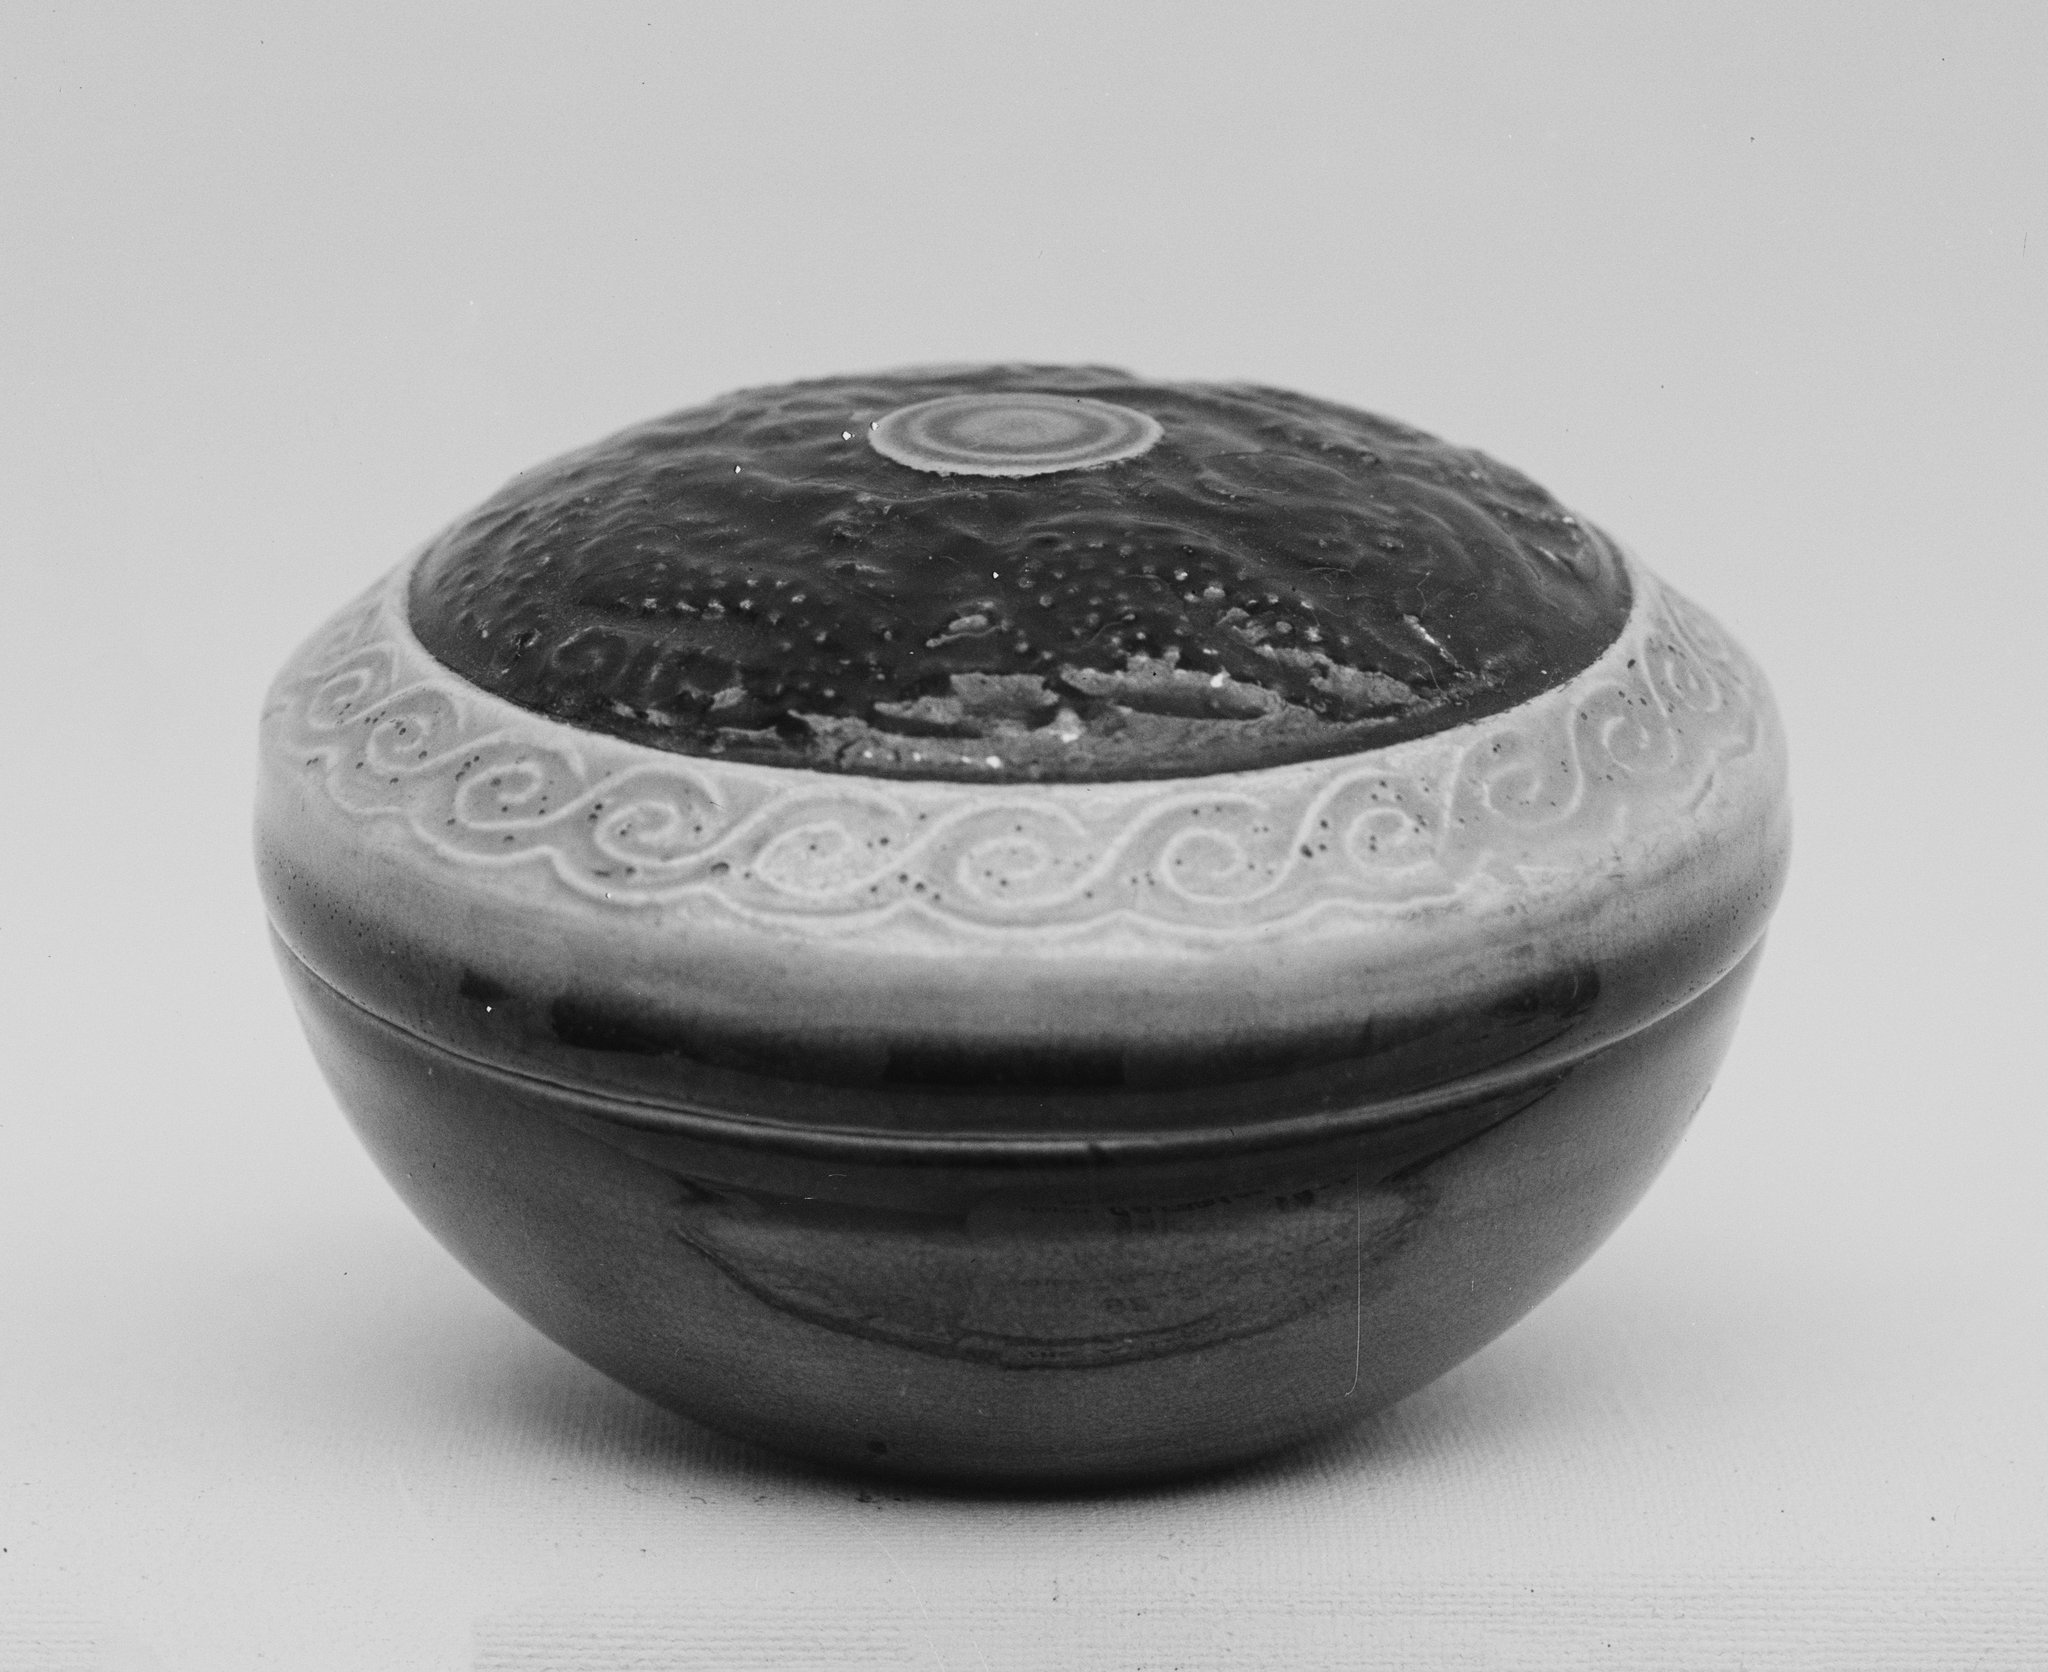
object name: incense box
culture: japanese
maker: eiraku hozen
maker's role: artist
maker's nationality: japanese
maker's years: 1795-1854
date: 1800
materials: clay, glaze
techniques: polychrome